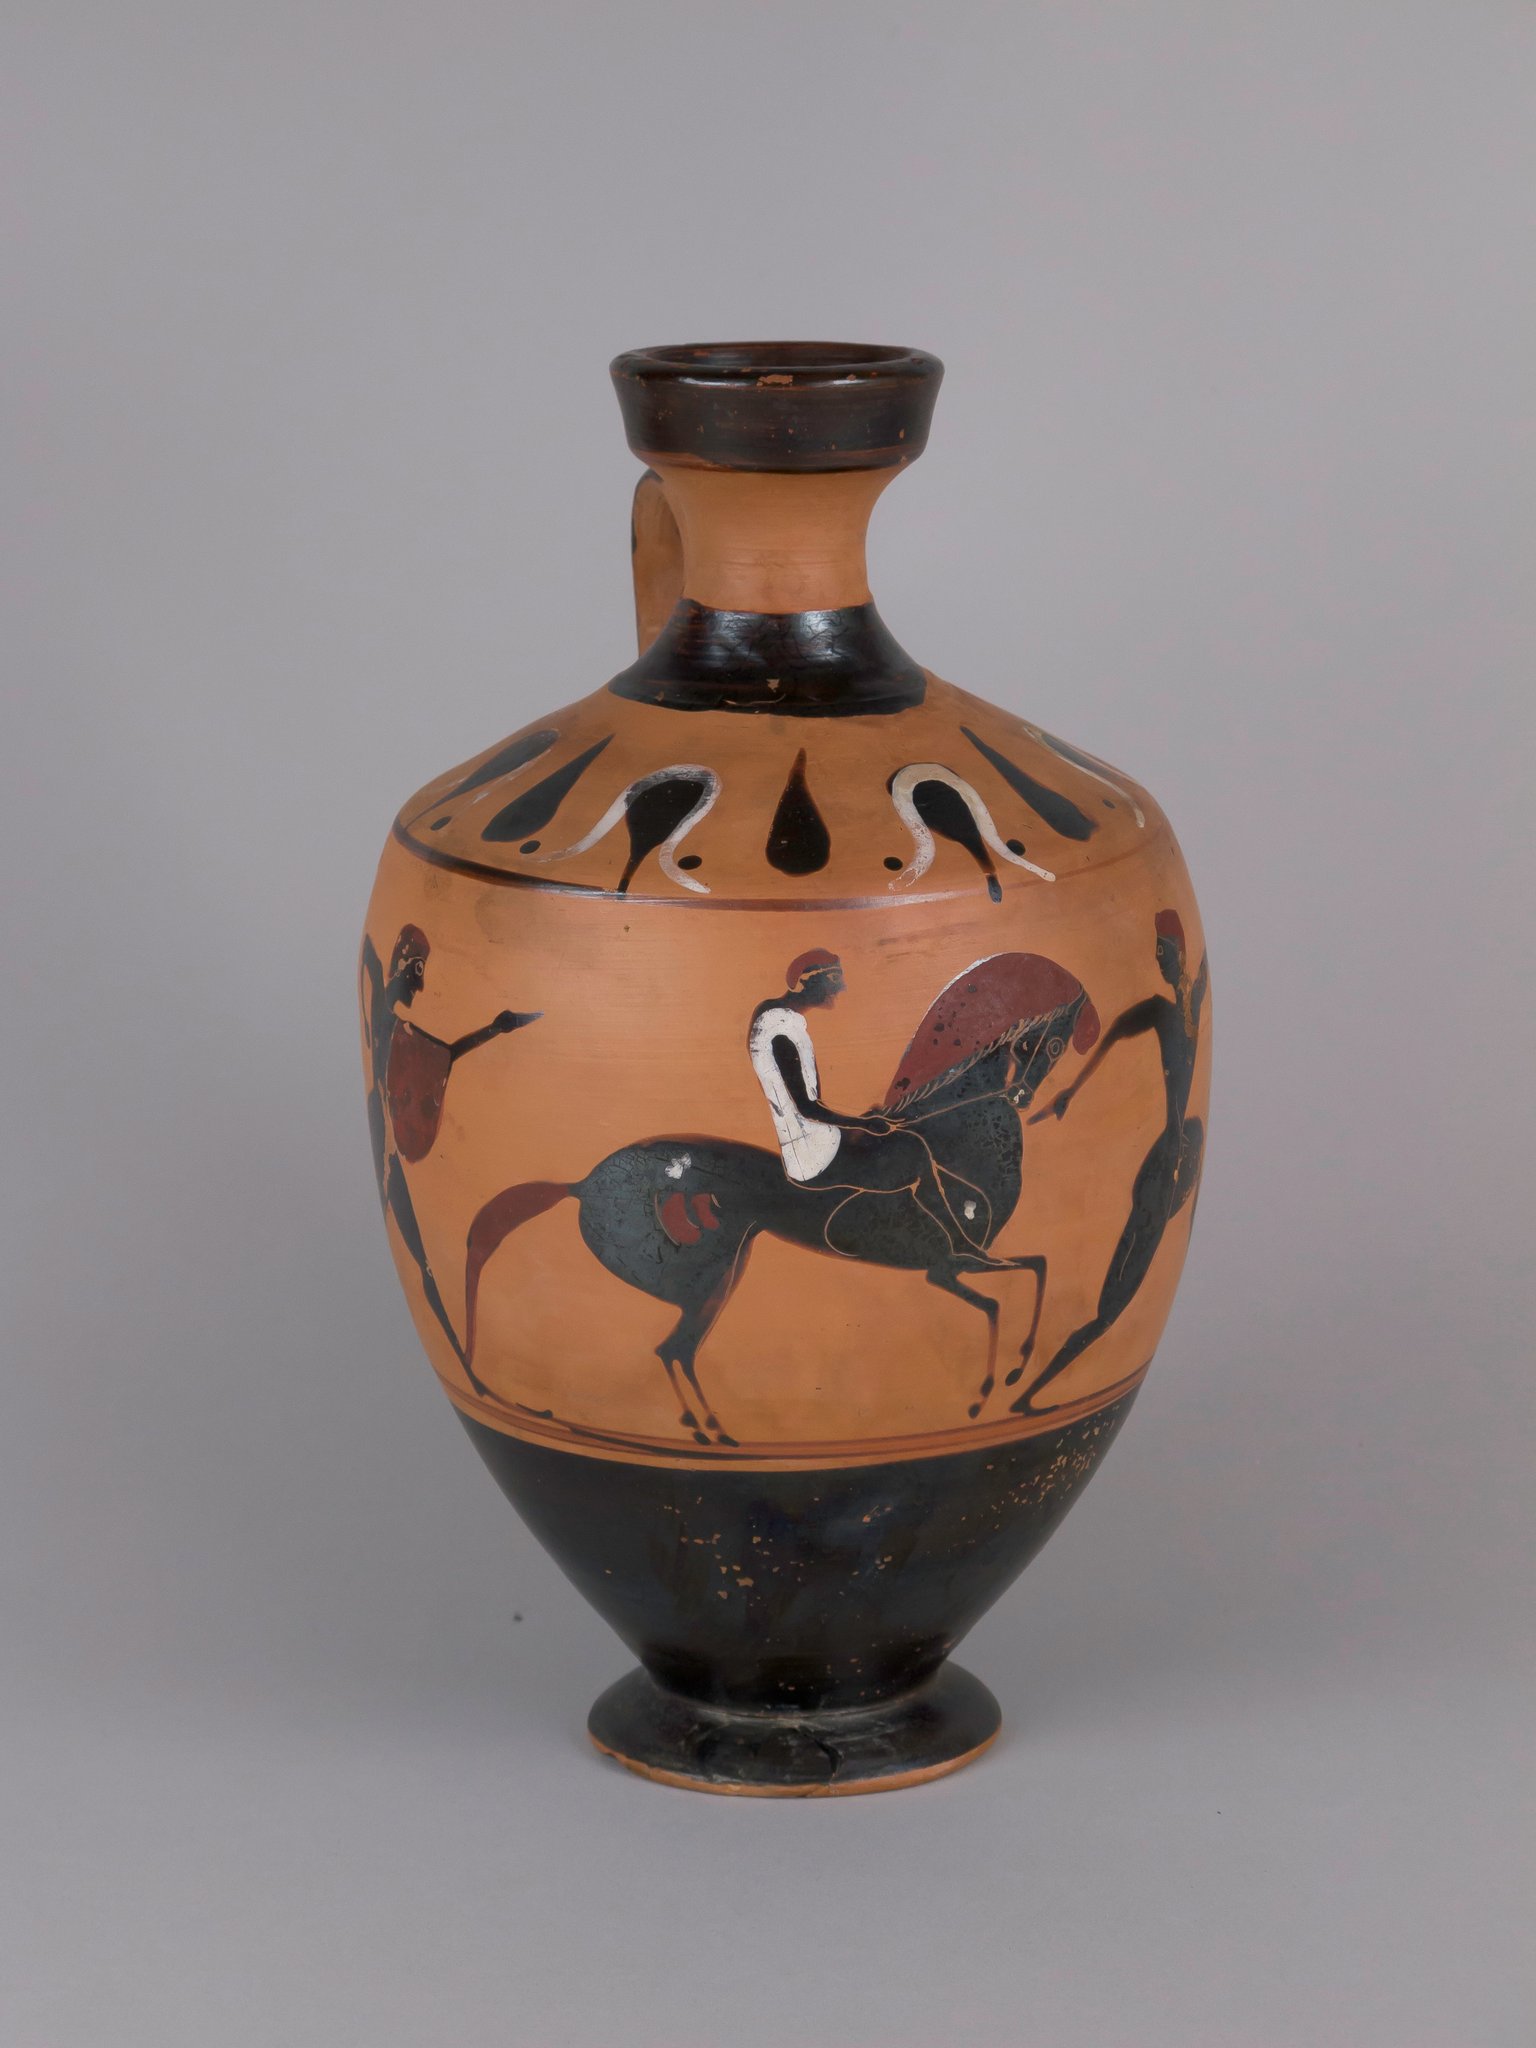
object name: lekythos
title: Terracotta lekythos (oil jar)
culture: greek, euboean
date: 560 BCE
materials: terracotta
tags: men,horses